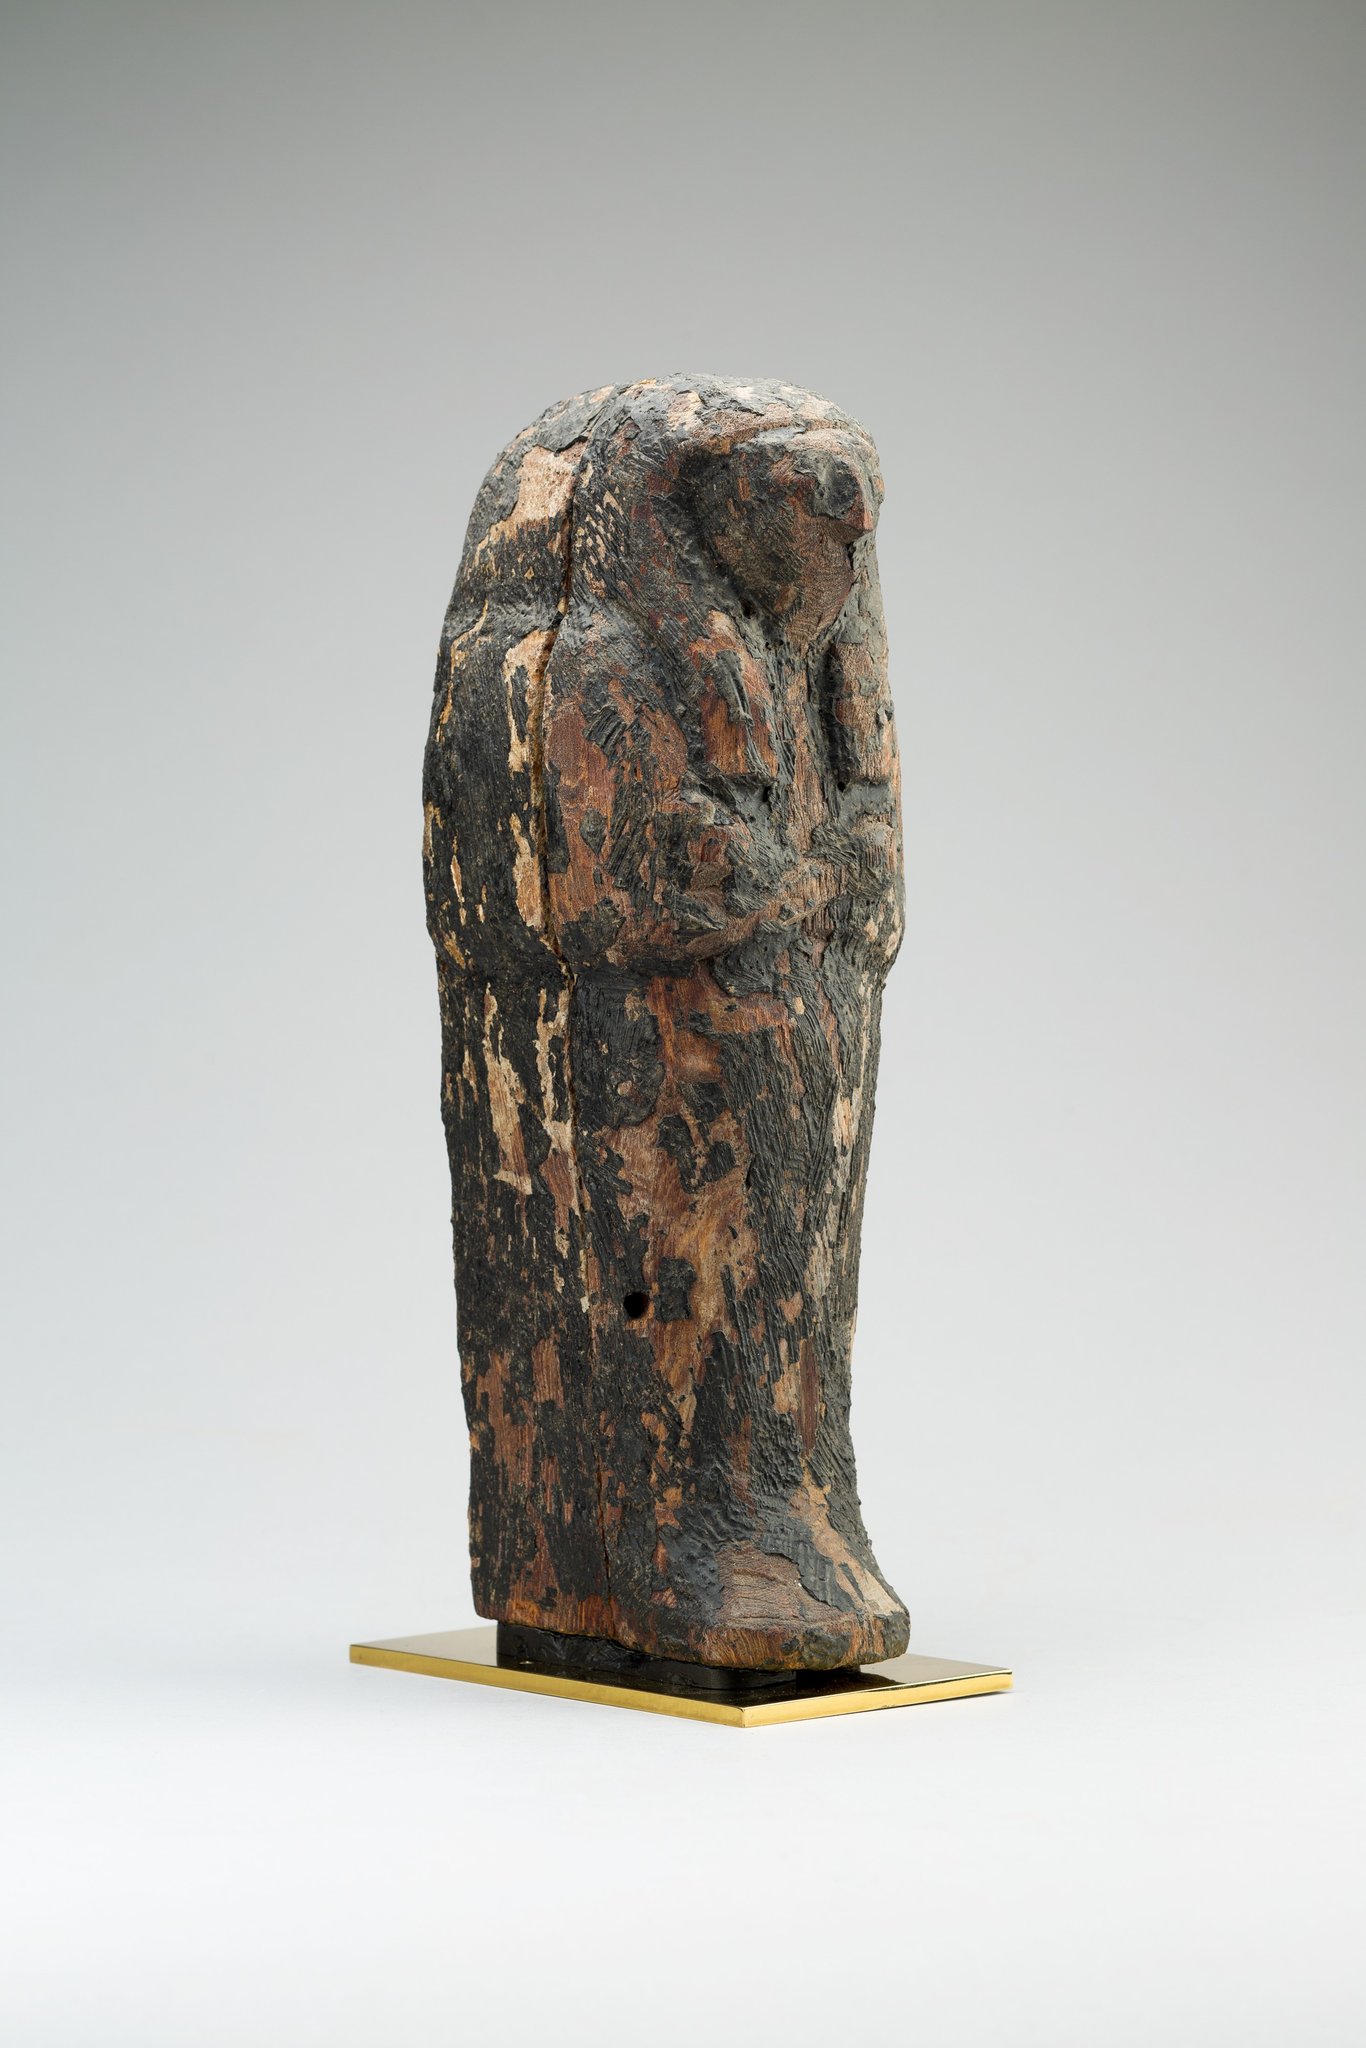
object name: canopic coffin, qebehsenuef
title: Canopic Coffin in the form of Qebehsenuef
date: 924-889 BCE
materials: paint, plaster, wood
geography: egypt